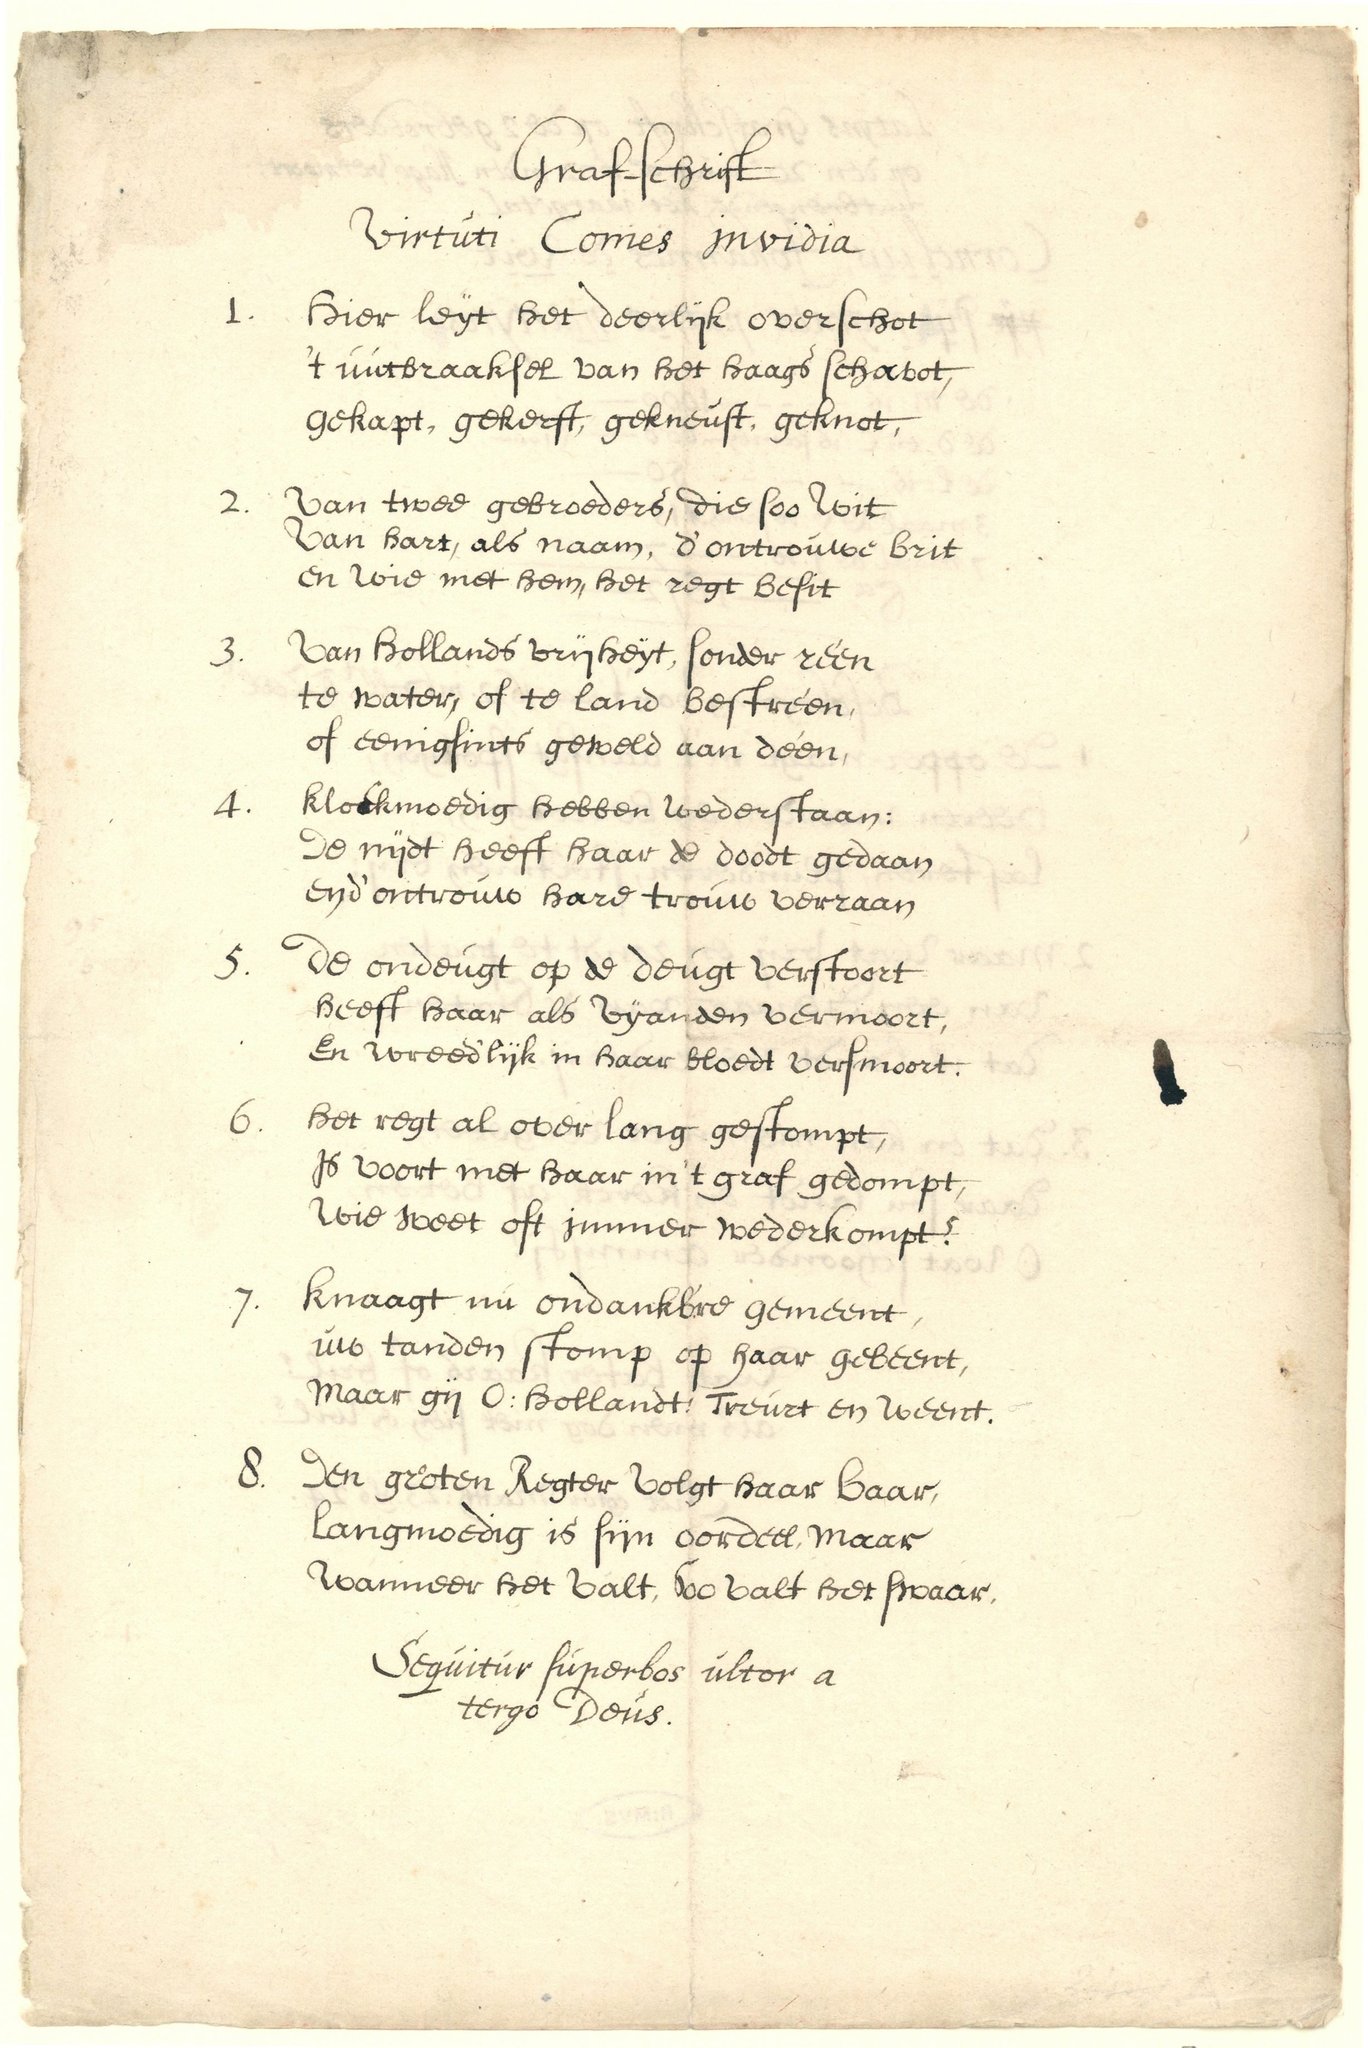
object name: manuscript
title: Grafschriften op de gebroeders De Witt, 1672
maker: Anonymous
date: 1672-1699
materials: paper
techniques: writing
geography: northern netherlands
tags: dordrecht, the hague, cornelis de witt, politician, johan de witt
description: Blad met op beide zijden handgeschreven verzen naar aanleiding van de dood van Johan en Cornelis de Witt. Op voorzijde een grafschrift van acht genummerde verzen met de titel 'Virtuti Comes invidia' en met de aanhef 'Hier leyt het deerlyk overschot'. Op de achterkant een korte vers in het Latijn en een Nederlands vers van drie coupletten getiteld 'Beschrijving van 't jaar 1672 in Holl.t & Zeel.t.' Wellicht zijn de teksten overgeschreven van pamfletten (vergelijk Knuttel nr. 10446).